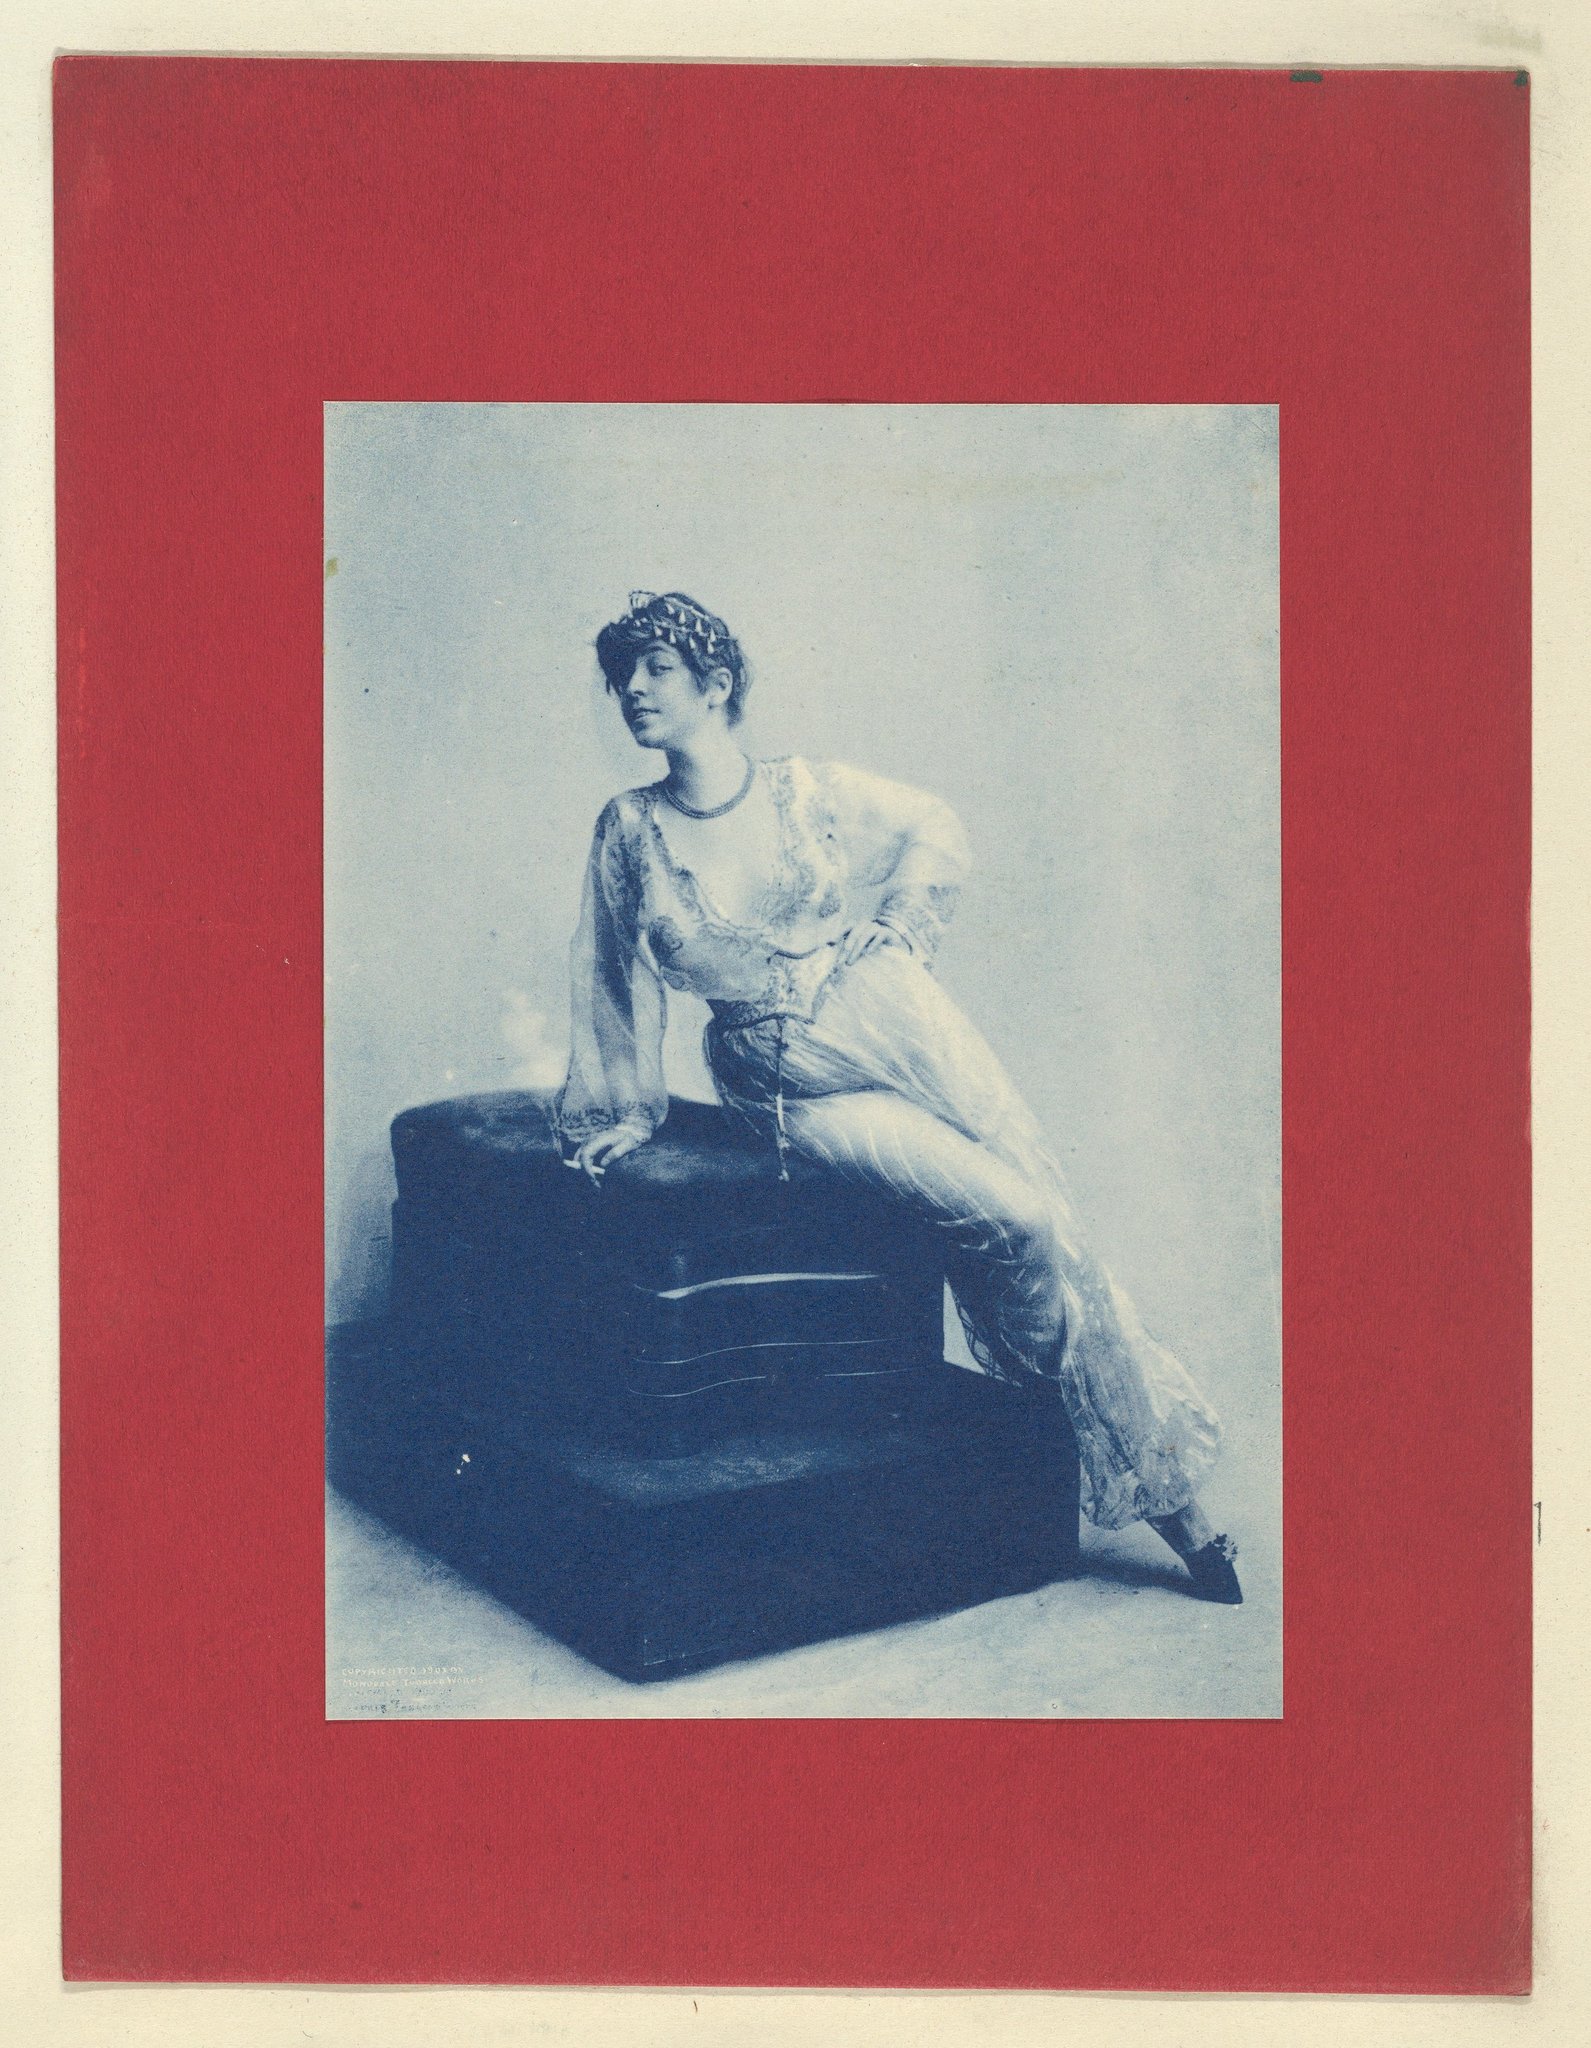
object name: print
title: Plate 12, from Little Egypt Actresses series (T2), issued by Monopole Tobacco Works to promote Khedive Egyptian Cigarettes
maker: monopole tobacco works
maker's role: publisher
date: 1902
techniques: photolithograph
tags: portraits,women,actresses